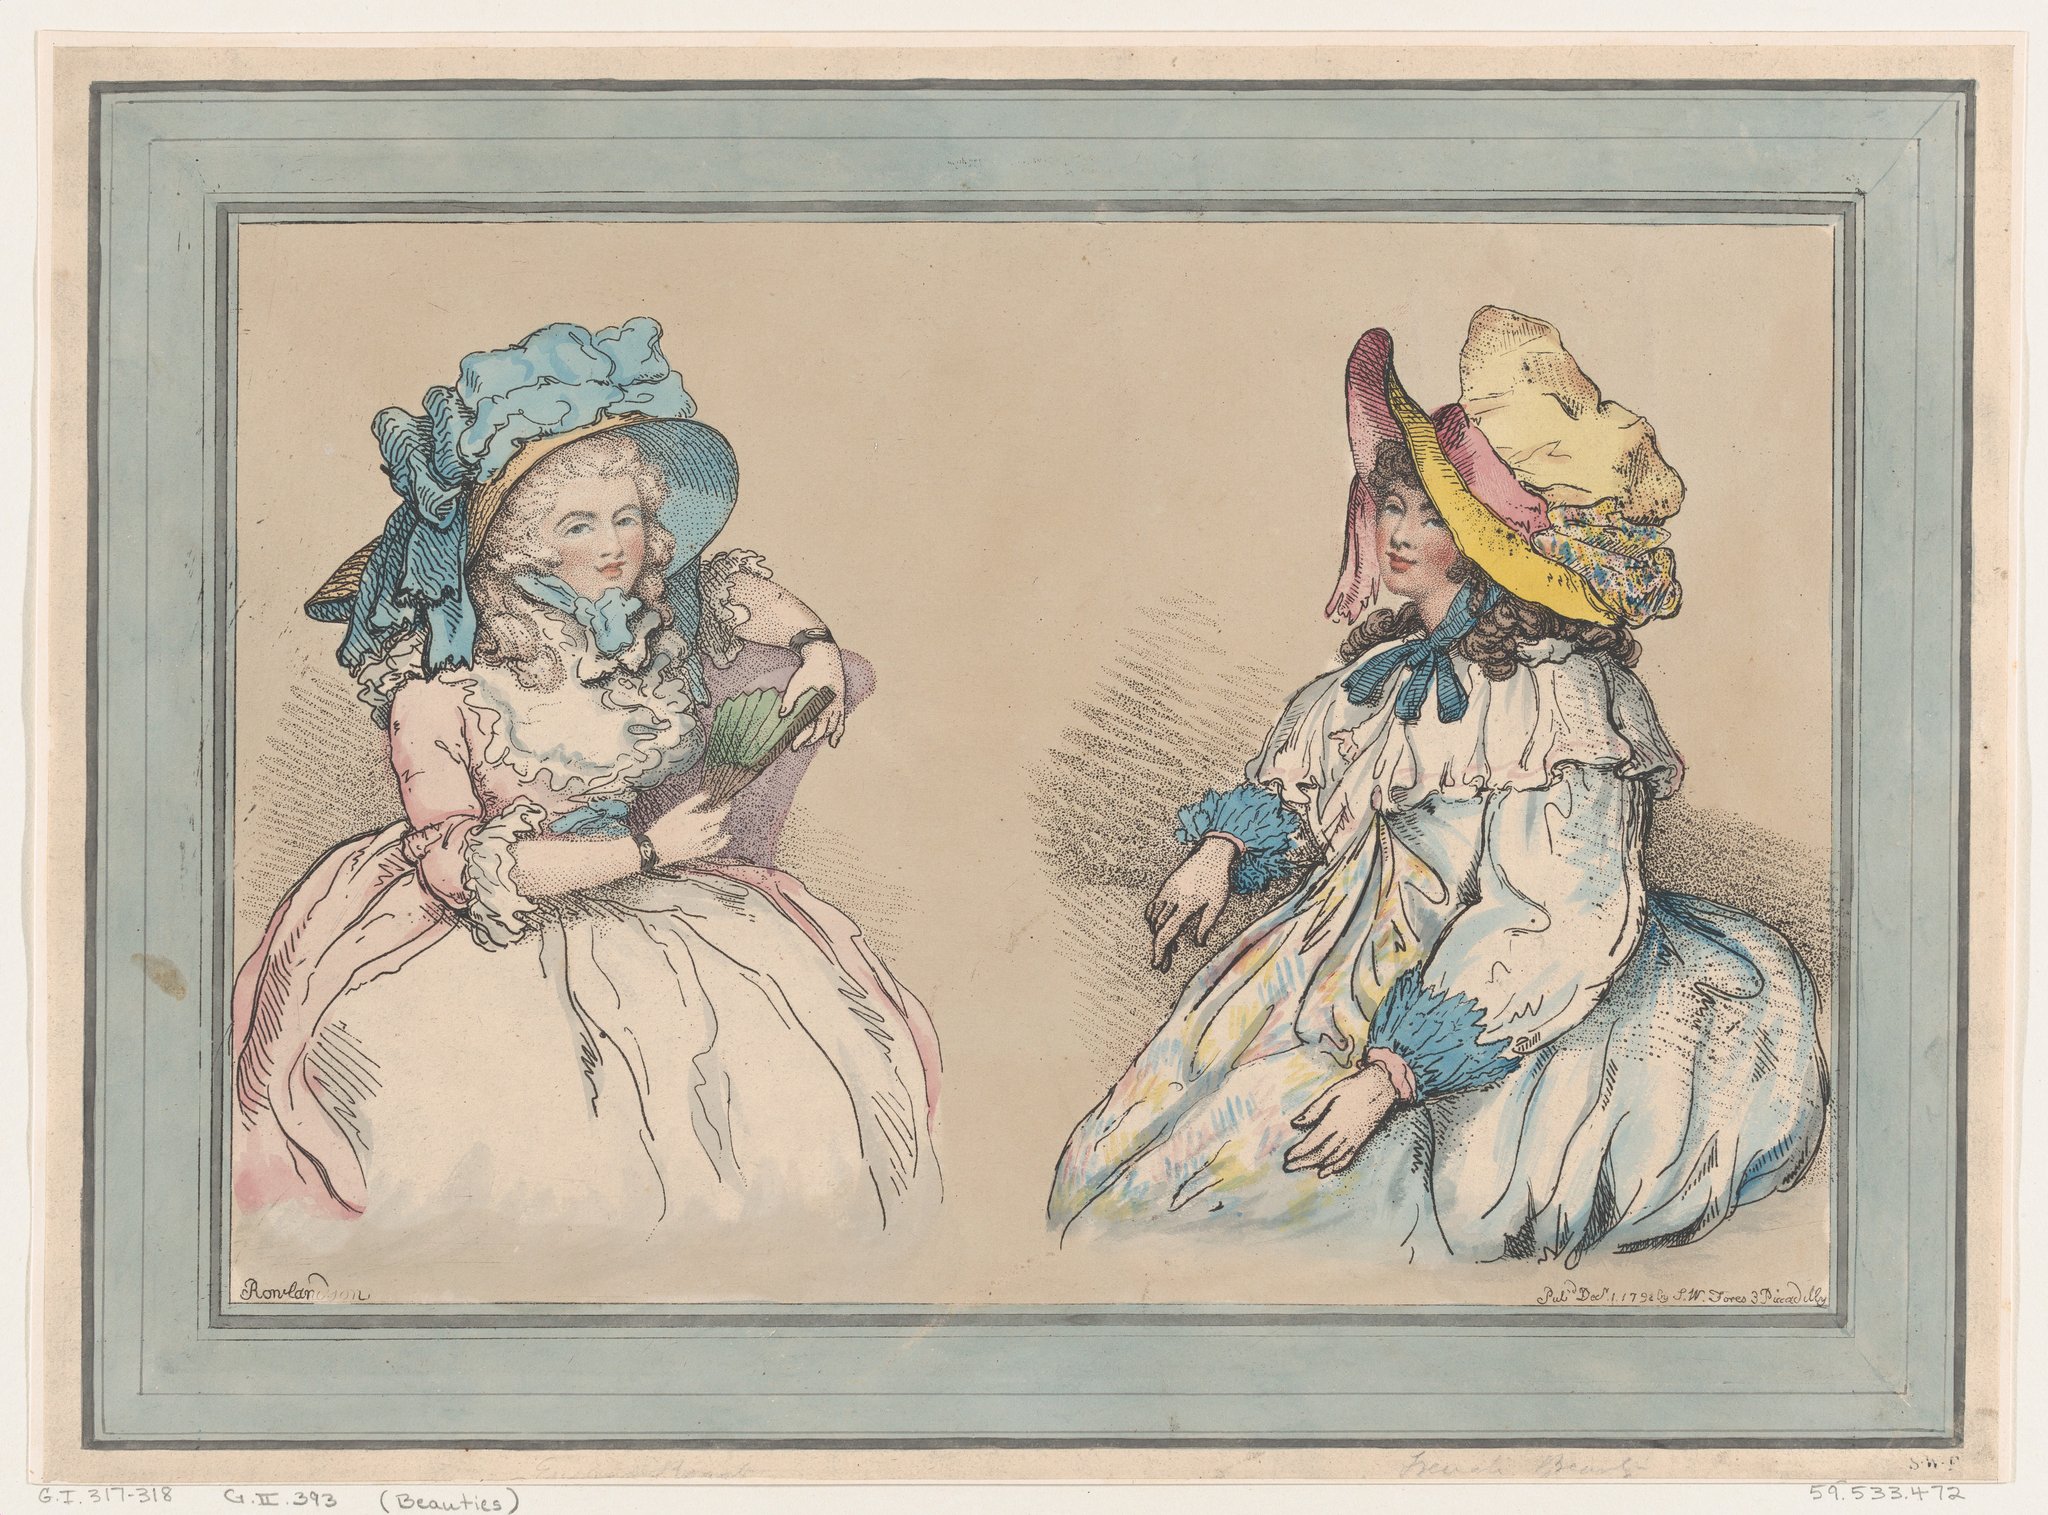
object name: print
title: Beauties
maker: thomas rowlandson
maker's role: artist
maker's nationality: british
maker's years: 1757-1827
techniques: etching, hand coloring, engraving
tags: women